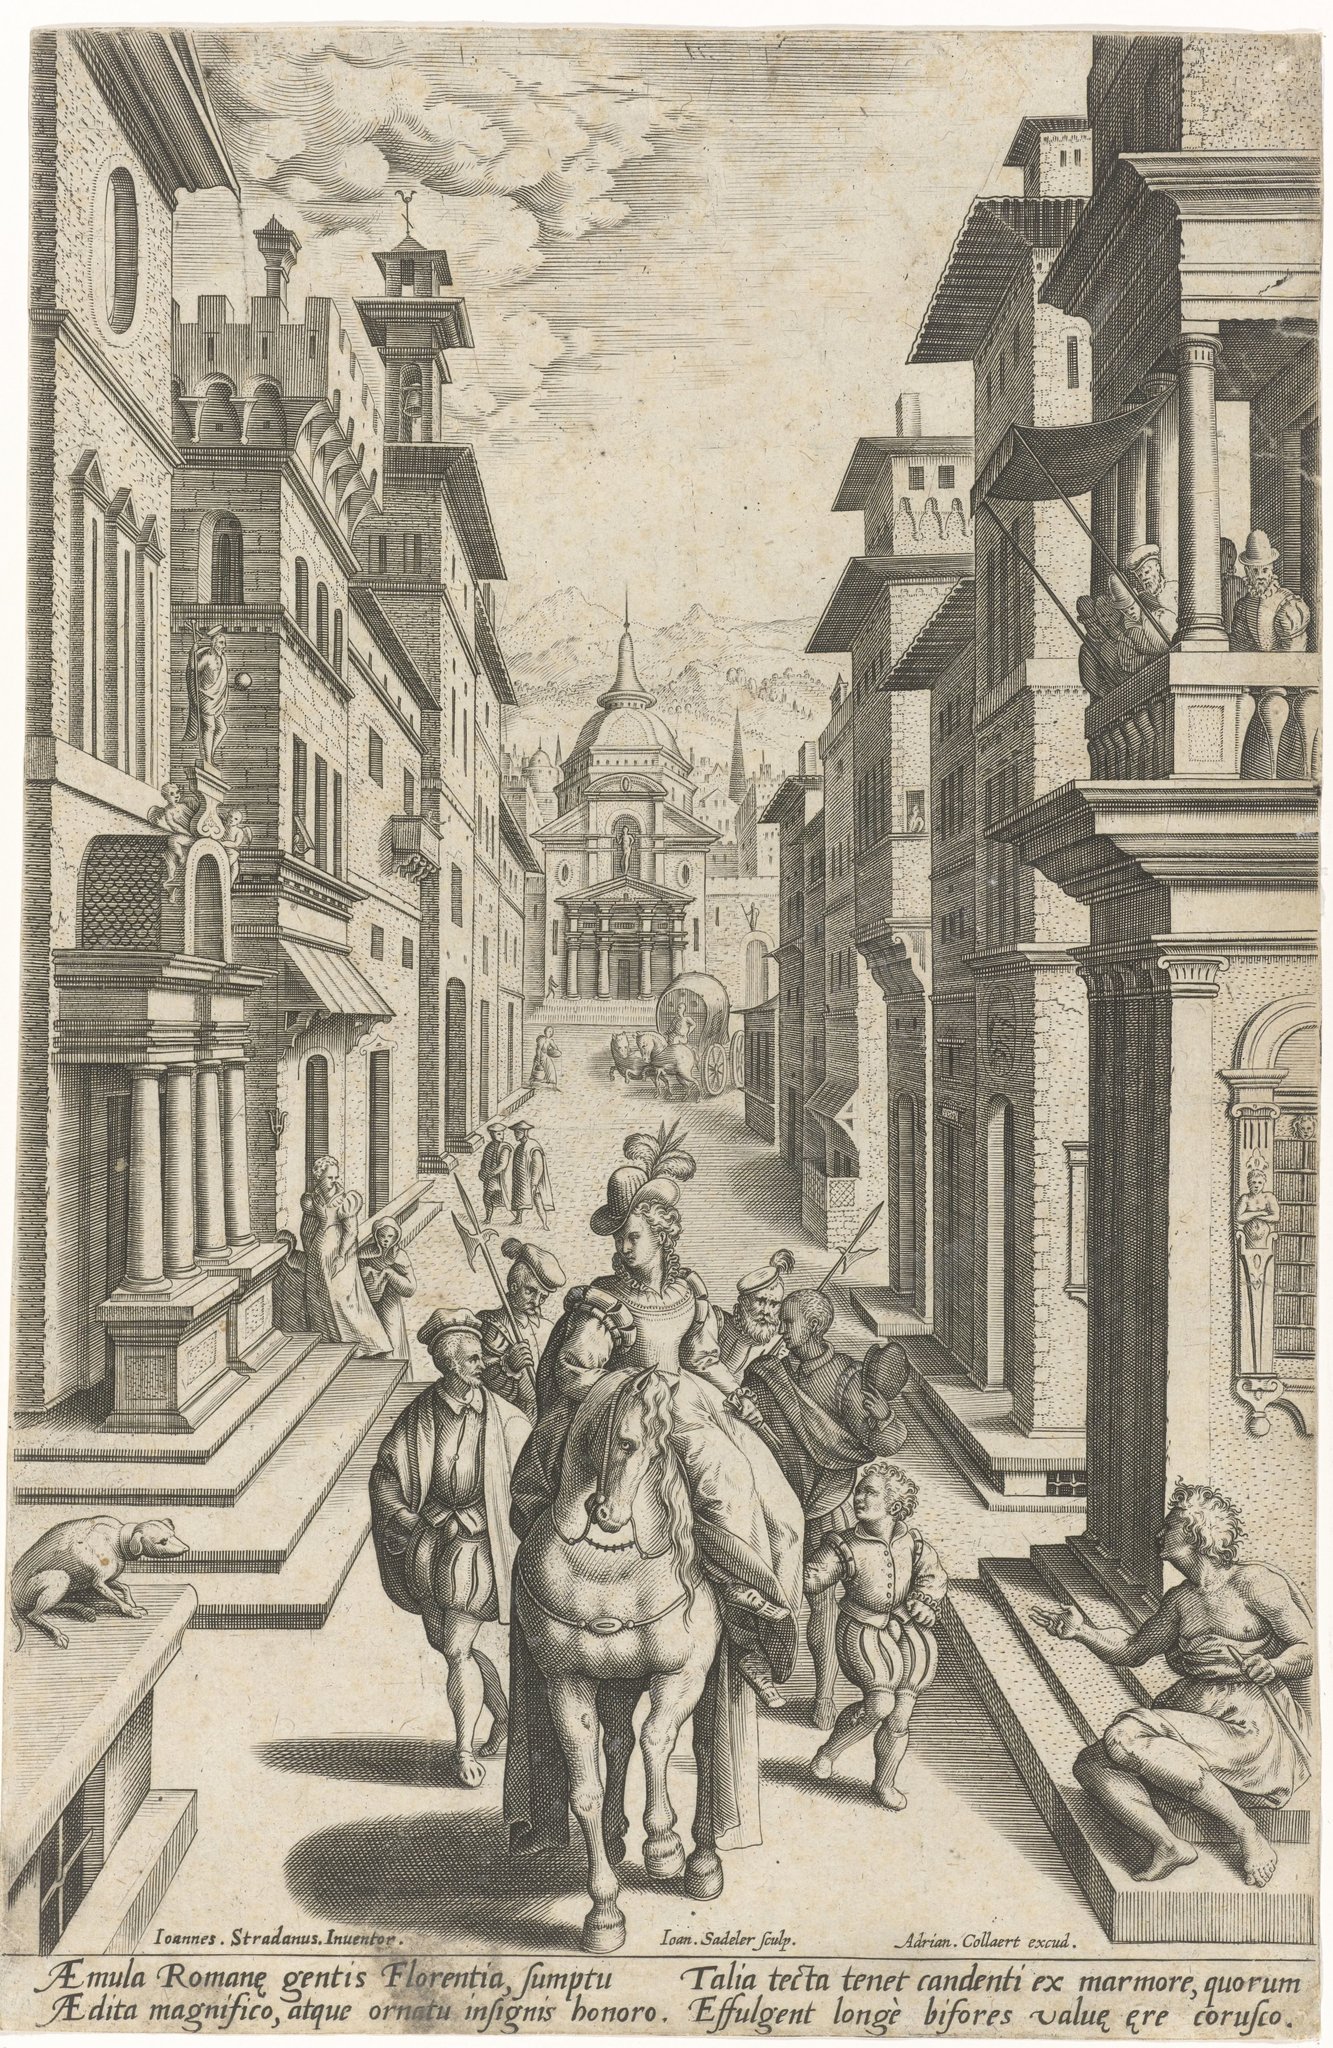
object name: print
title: Dame te paard in Florence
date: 1601-1618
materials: paper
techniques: engraving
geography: antwerp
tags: riding a horse, ass, or mule; rider, horseman, street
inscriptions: collector's mark: Lugt 2228, collector's mark: Lugt 698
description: Pendant van 'Neptunusfontein te Florence' (RP-P-1951-665). Naar de decoraties gemaakt door Stradanus voor de intrede van Johanna van Oostenrijk in Florence in 1565.